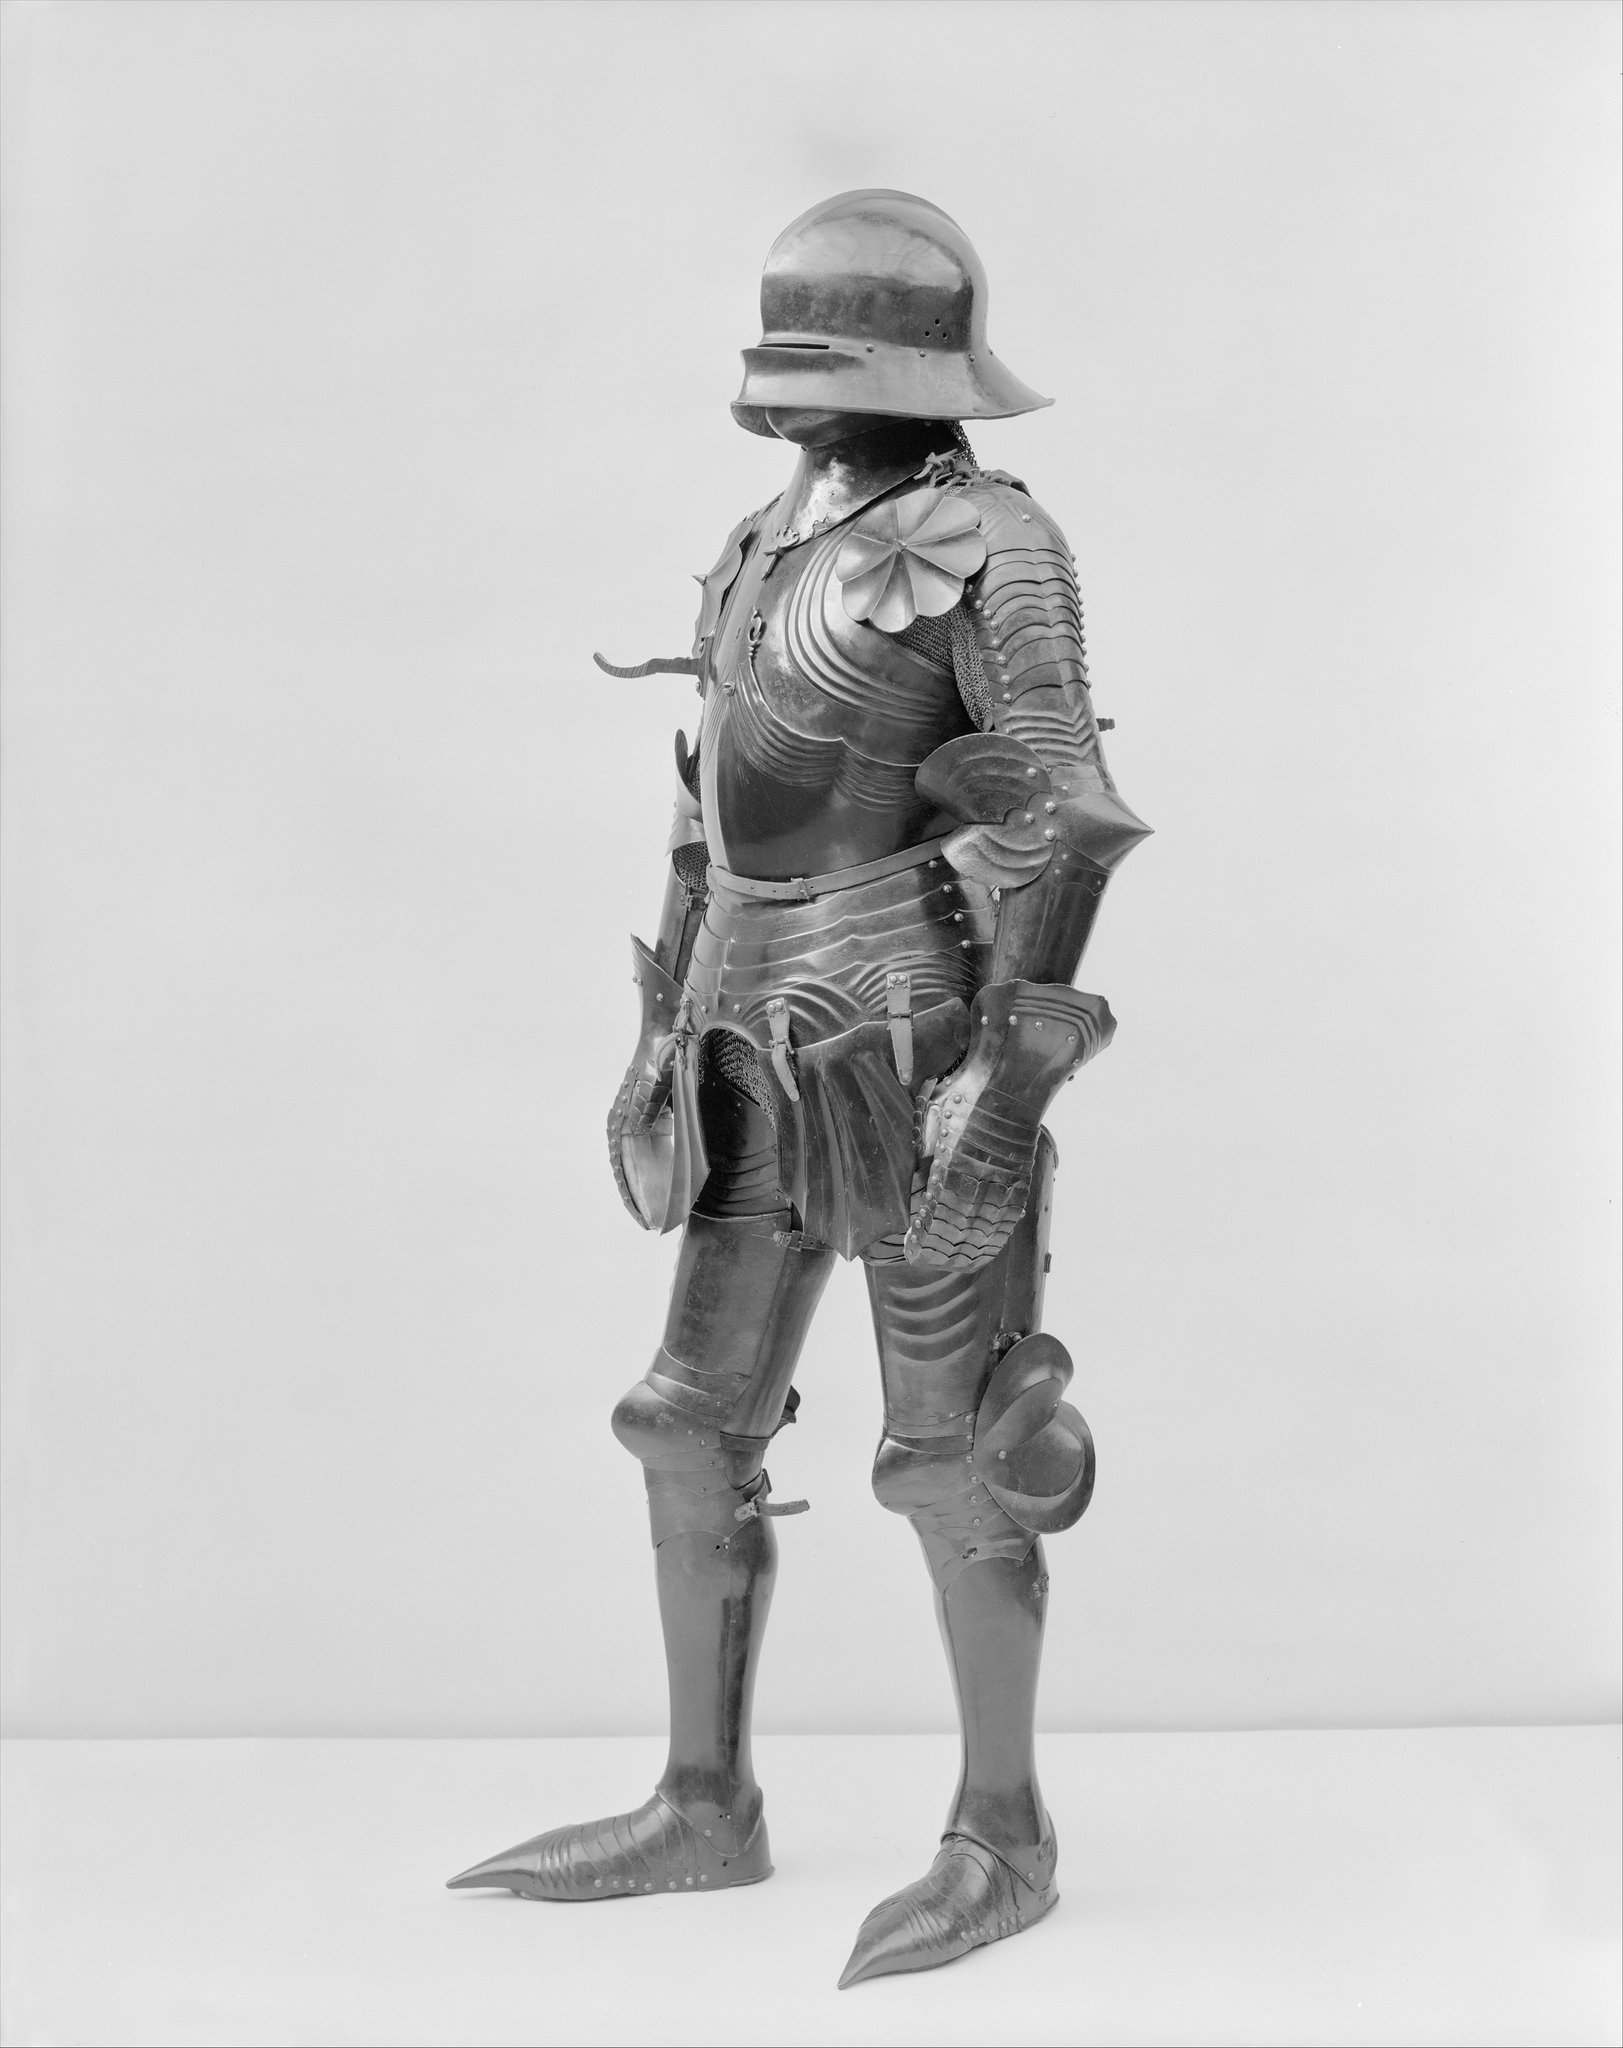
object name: armor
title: Gothic Armor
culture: german or italian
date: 1467-1500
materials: copper alloy, leather, steel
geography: germany